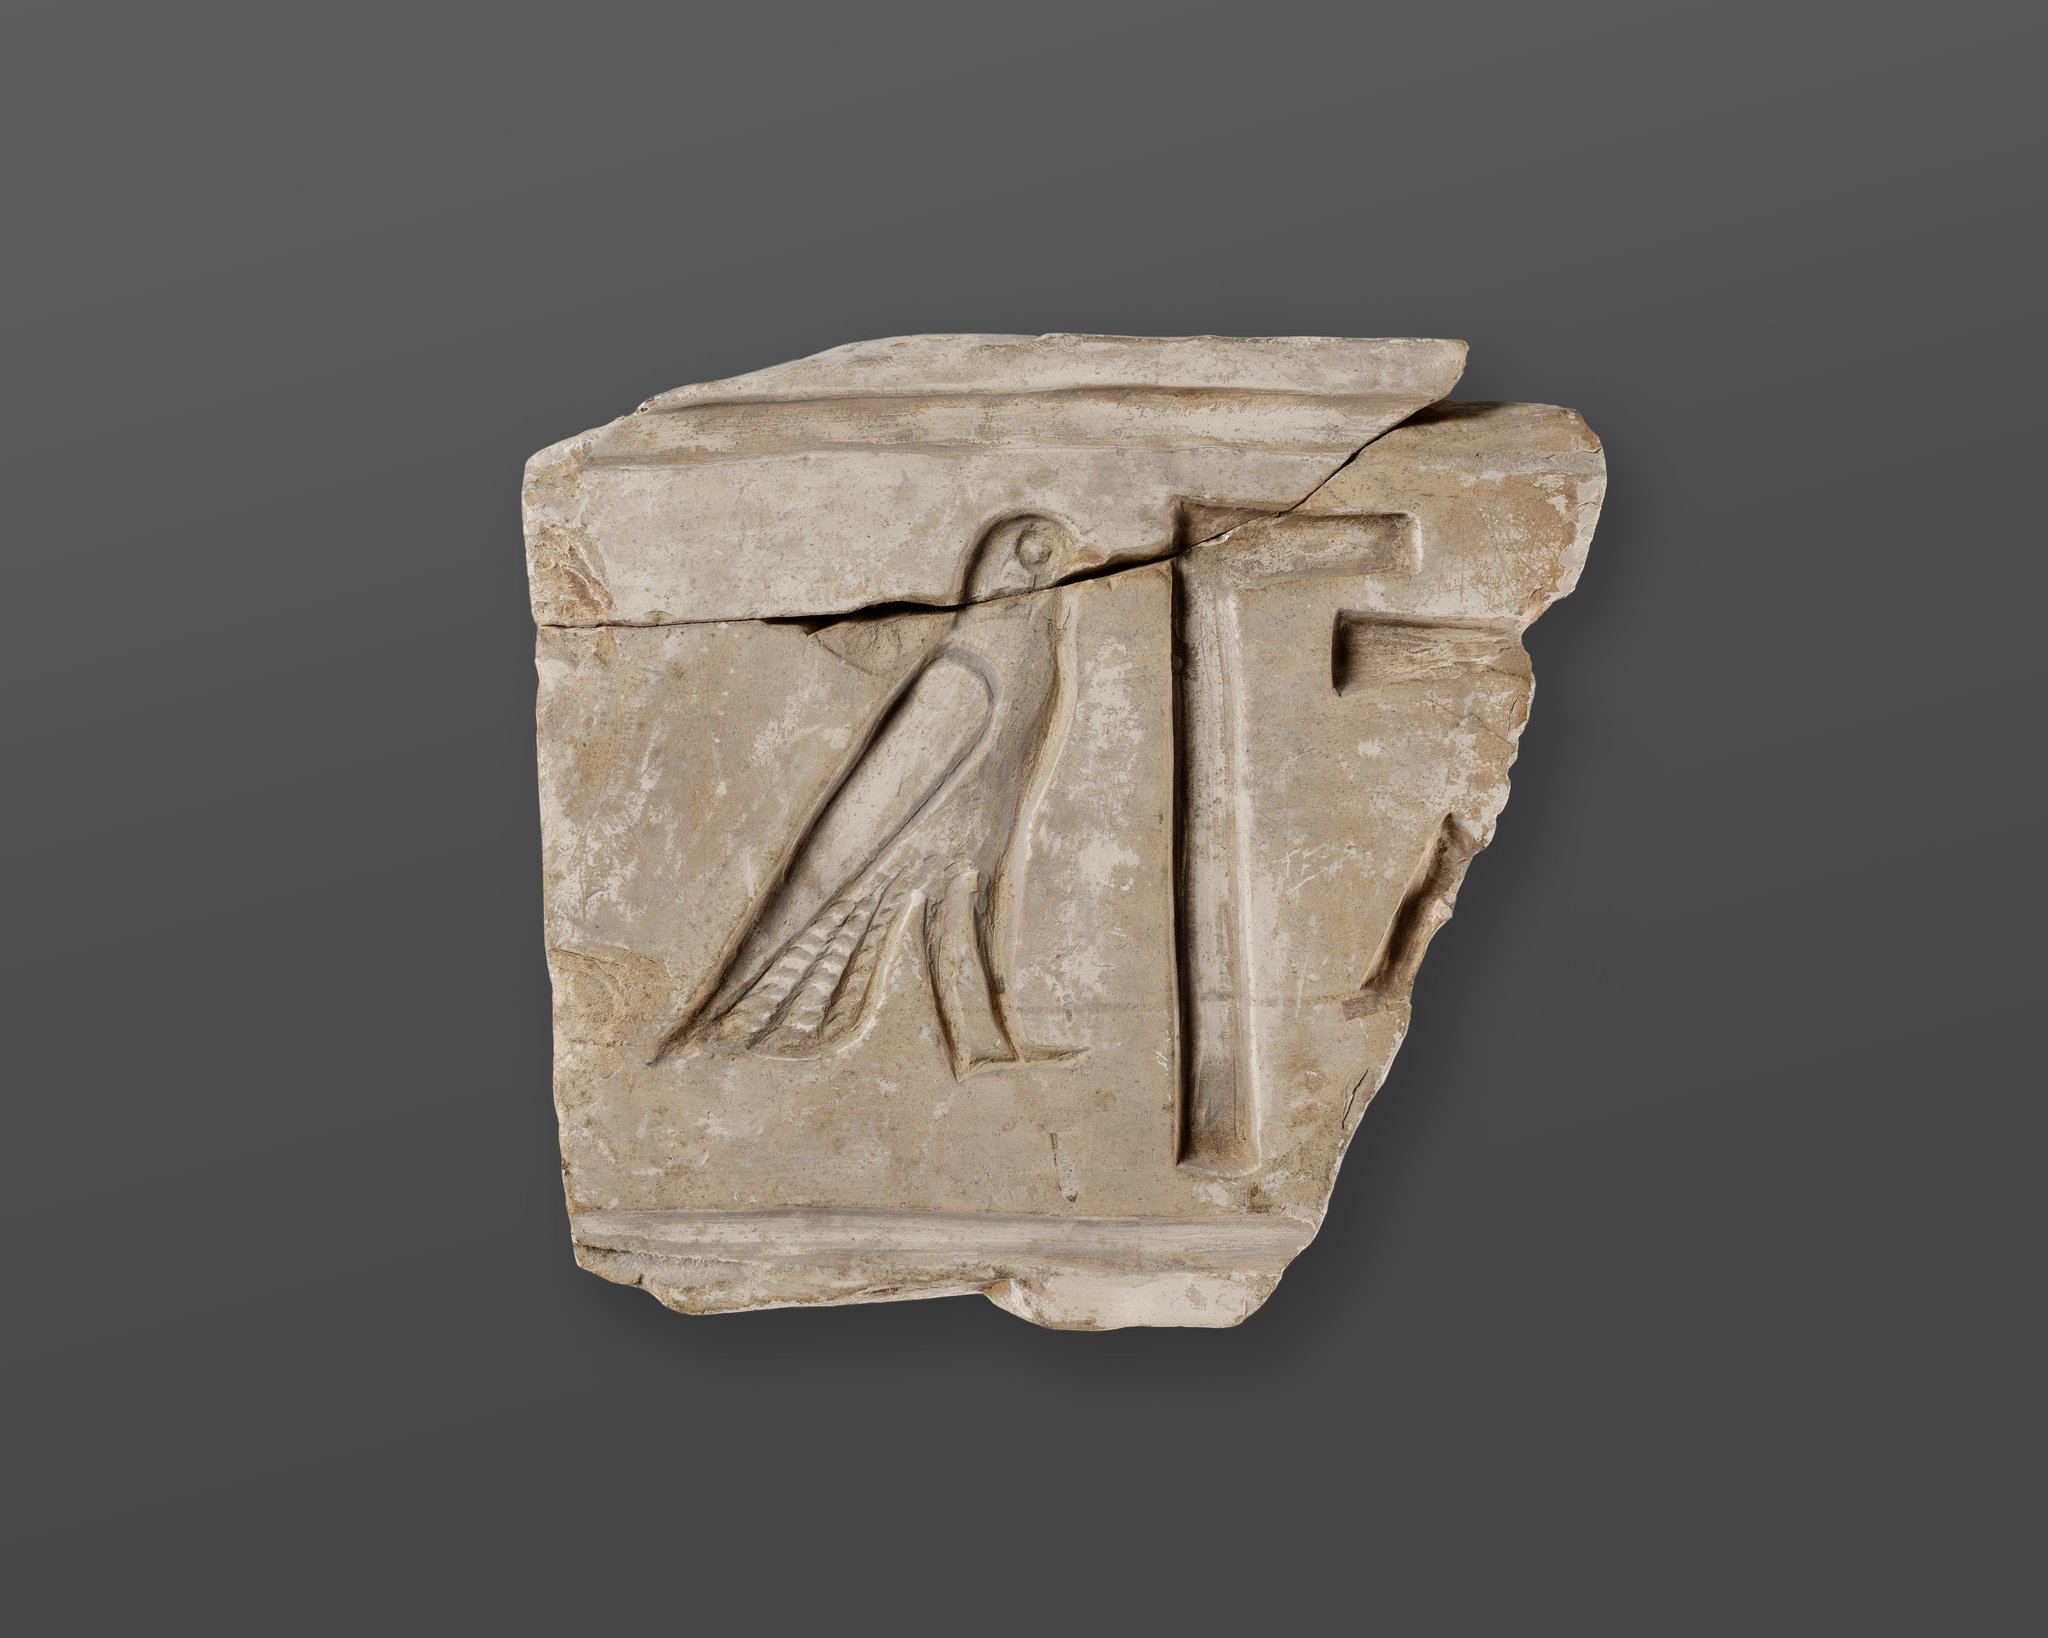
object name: relief fragment, tomb of mereri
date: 2100-2030 BCE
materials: limestone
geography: egypt